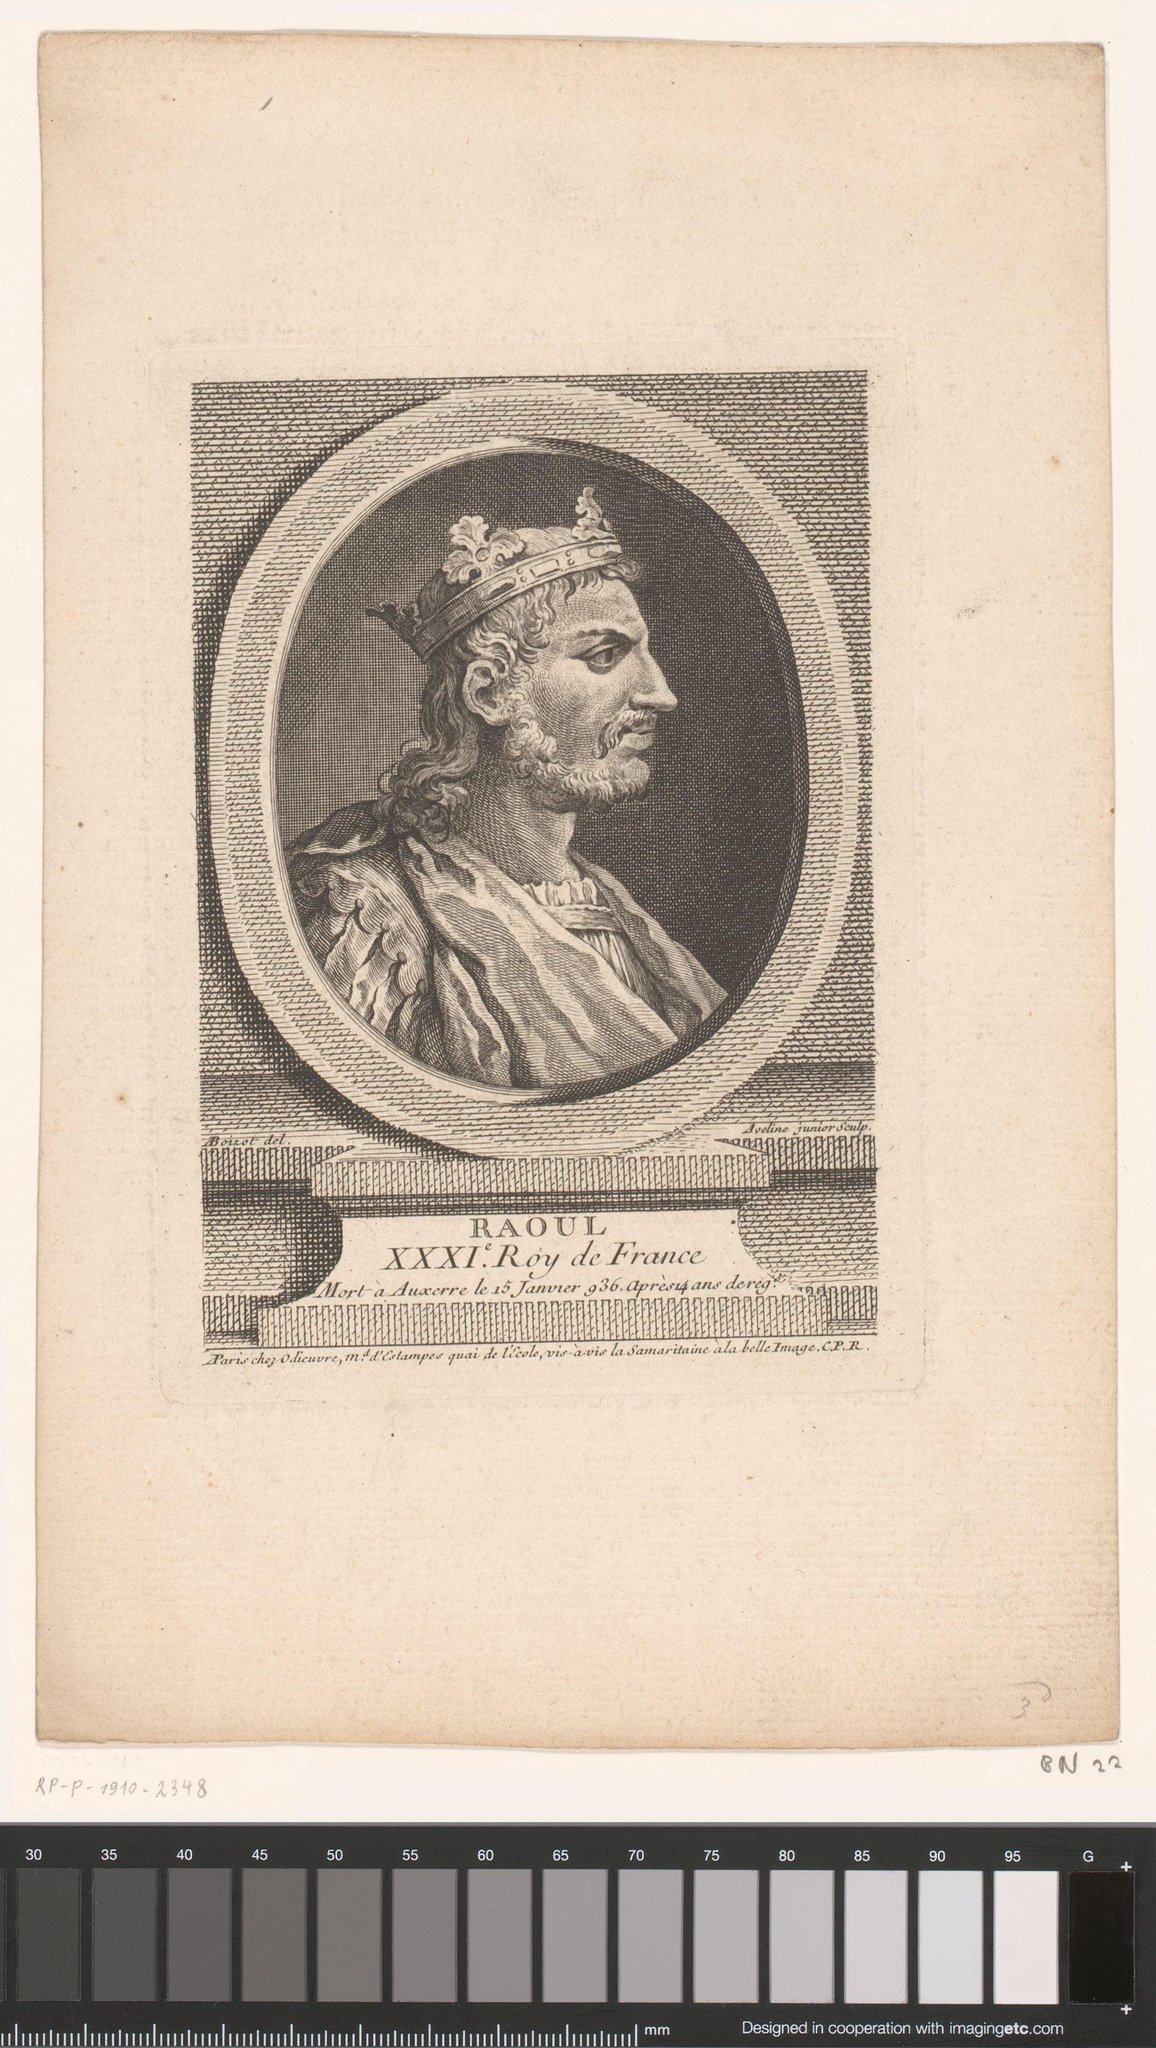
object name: print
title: Raoul XXXI.e roi de France (...)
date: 1755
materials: paper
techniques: engraving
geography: paris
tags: ornament ~ medallion, historical persons, ruler, sovereign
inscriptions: collector's mark: Lugt 2228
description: Prent uit: Dreux du Radier, Jean-François. L'Europe illustré, contenant l'histoire abregée des souverains, des princes, des prélats, des ministres, (...) en Europe: dans le XVe. siècle compris, jusqu'à présent. Parijs: Michel Odieuvre en André-François Le Breton, 1755, dl 1.